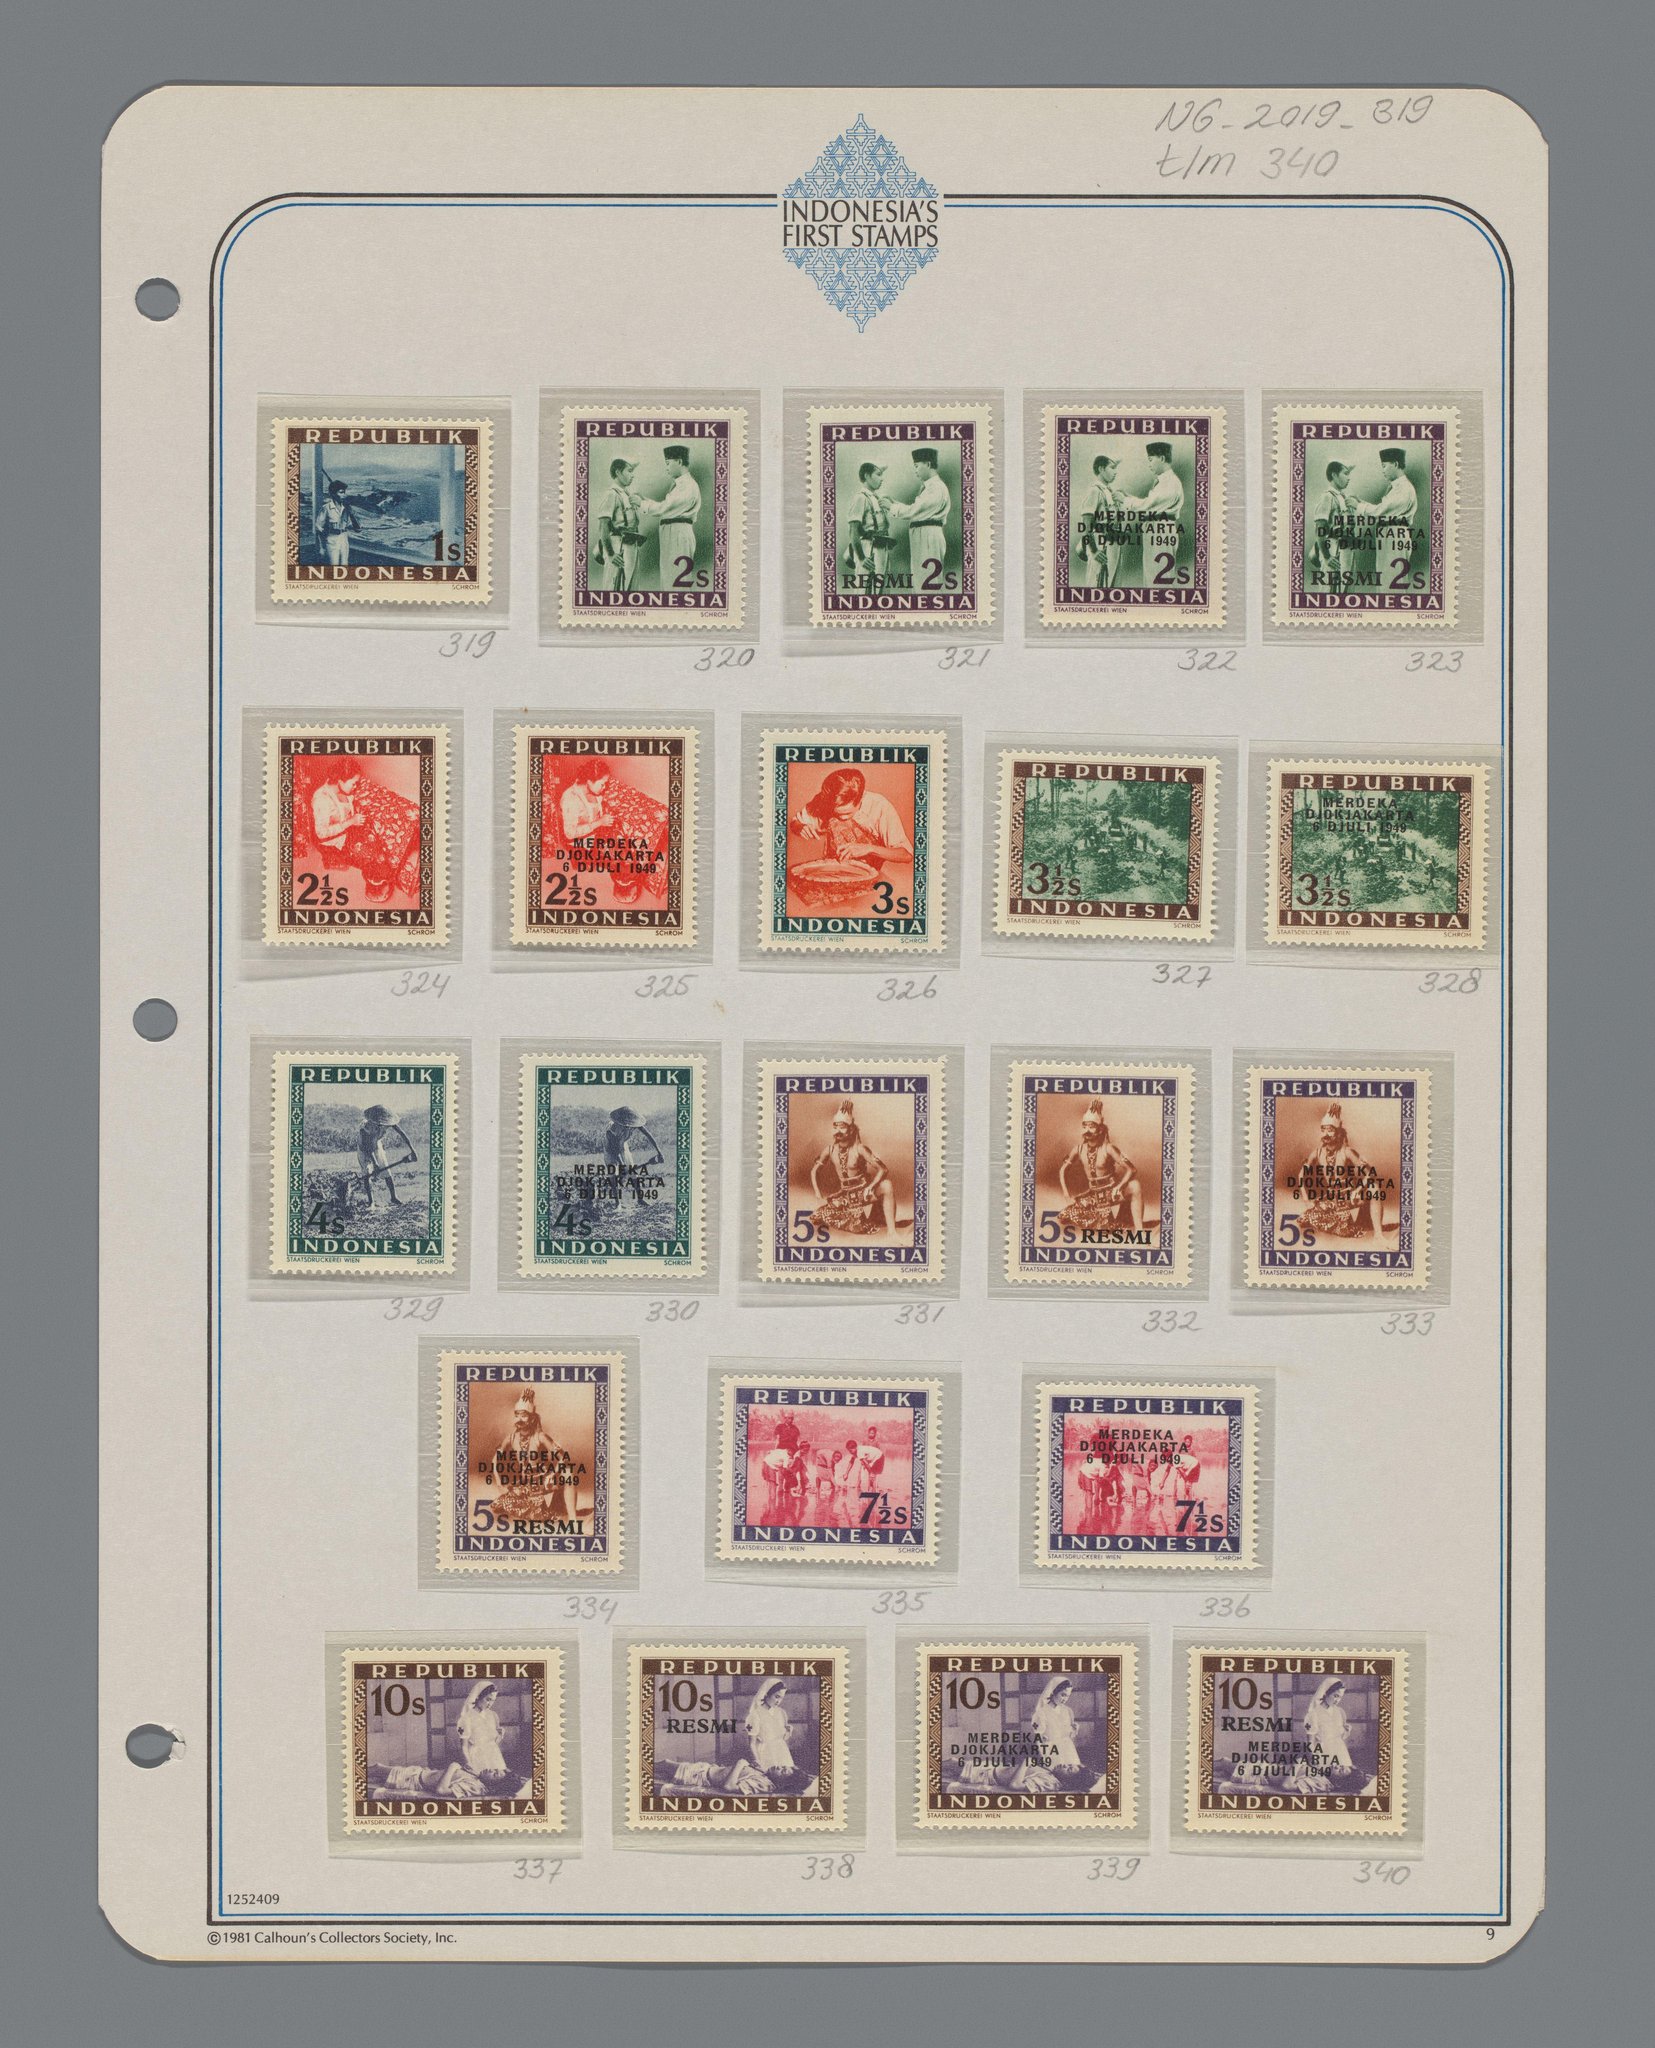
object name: postage stamp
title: Postzegel Republik Indonesia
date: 1949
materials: paper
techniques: photoaquatint, engraving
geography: vienna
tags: indonesia